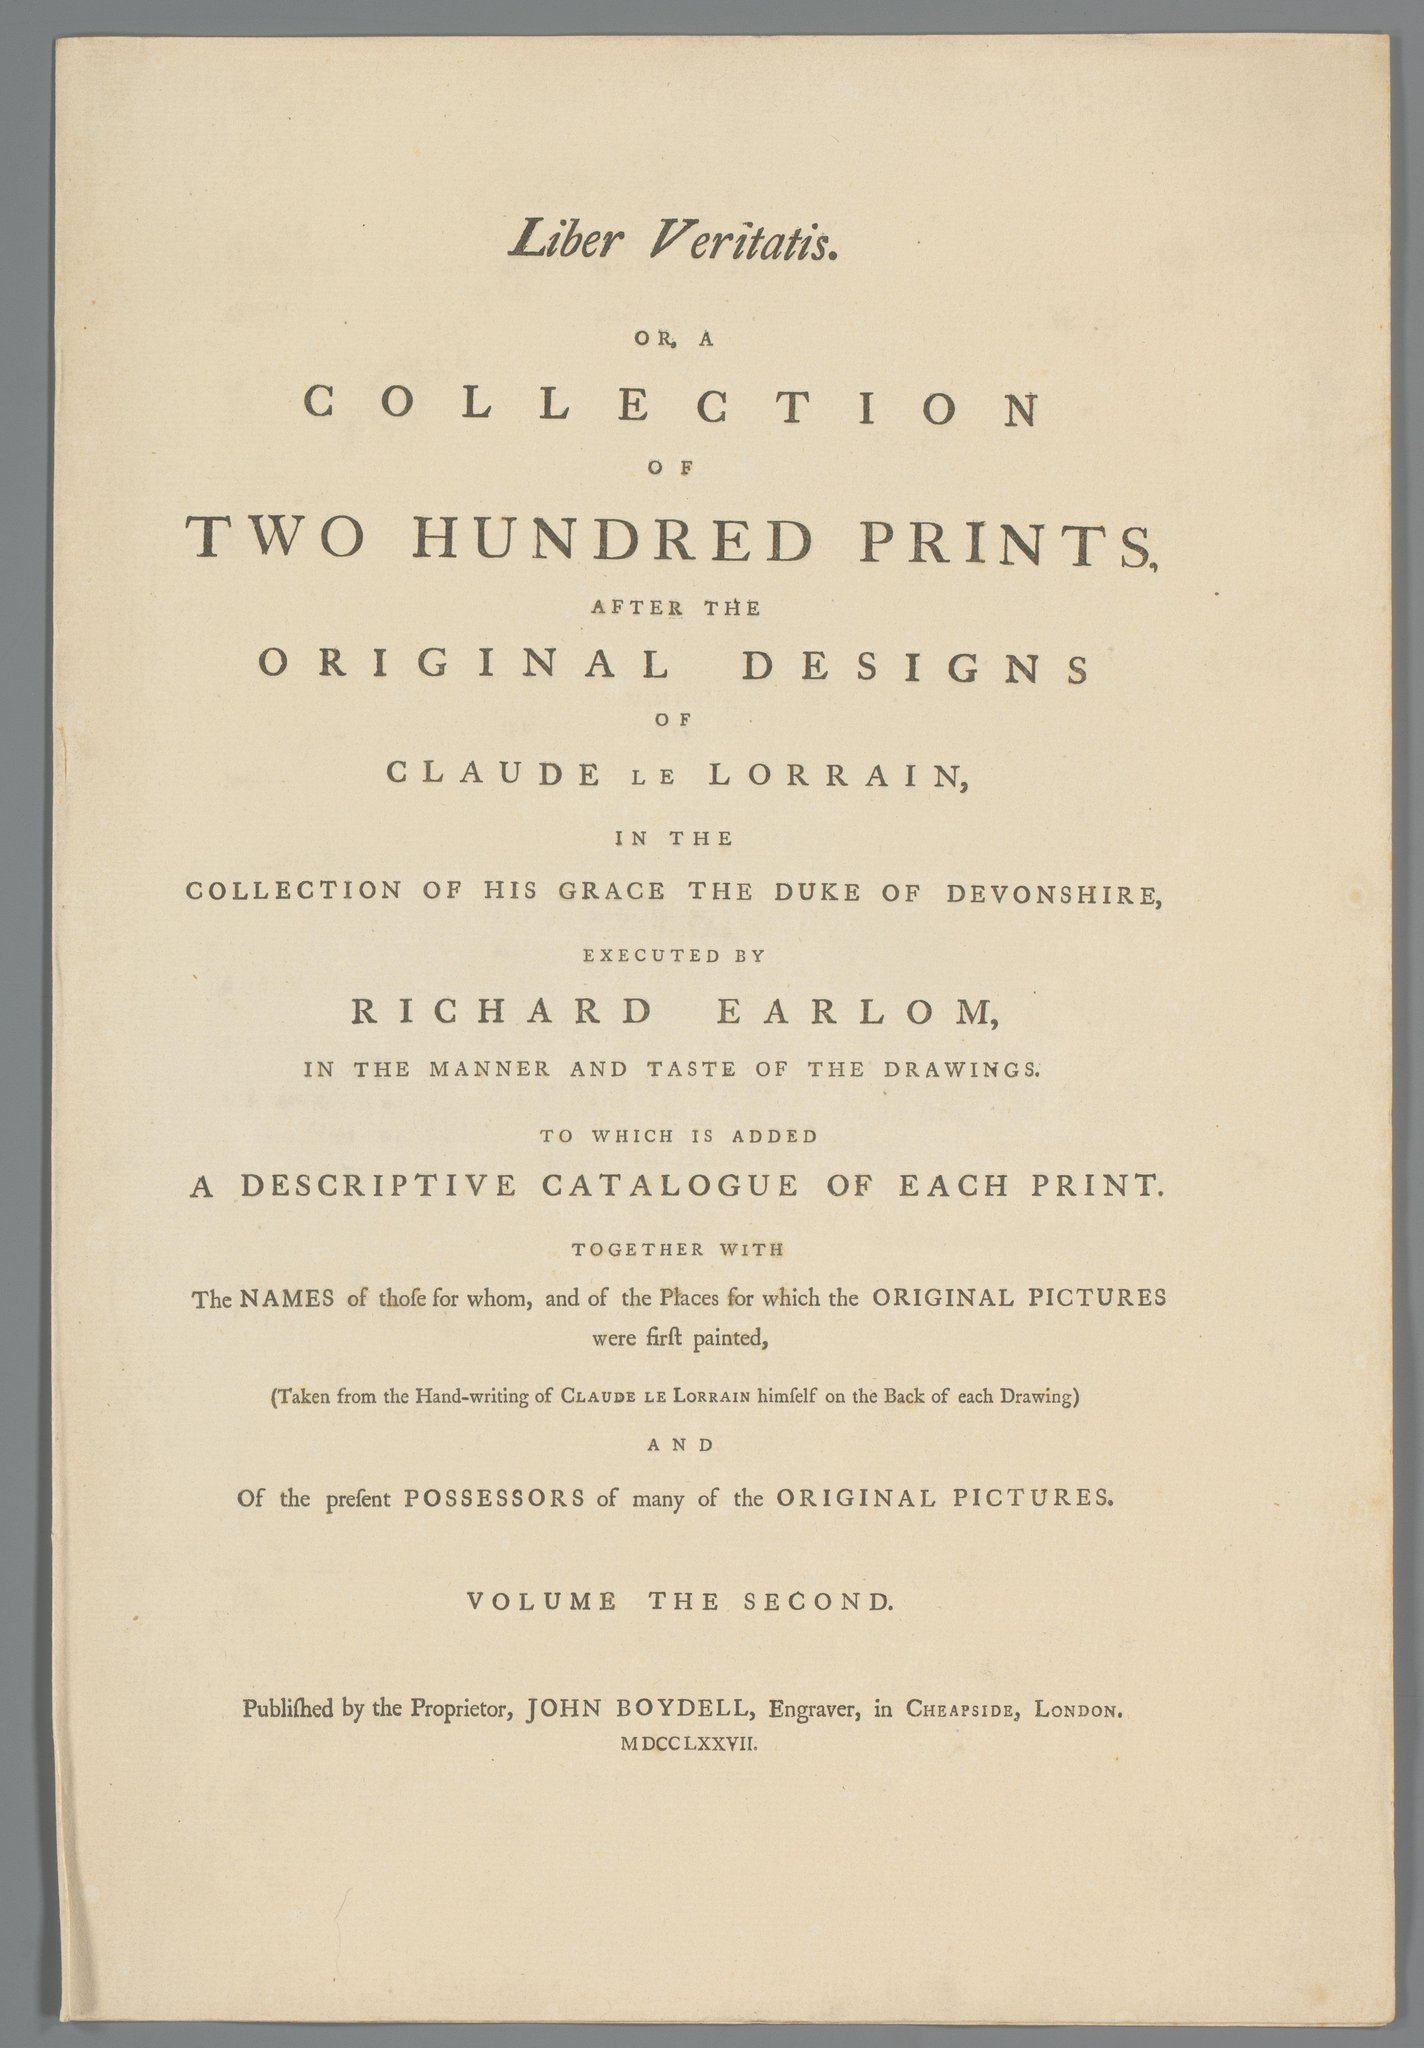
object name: text sheet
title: Prenten naar tekeningen van Claude Lorrain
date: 1777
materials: paper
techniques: letterpress printing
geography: london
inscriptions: date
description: Titelpagina voor: Earlom, Richard. Liber Veritatis. Or a Collection of Two Hundred Prints, after the original designs of Claude le Lorrain (...). Londen: John Boydell, 1777, dl. 2. Naar het tekeningenboek Liber Veritatis van Claude Lorrain, in het bezit van de hertogen van Cavendish.